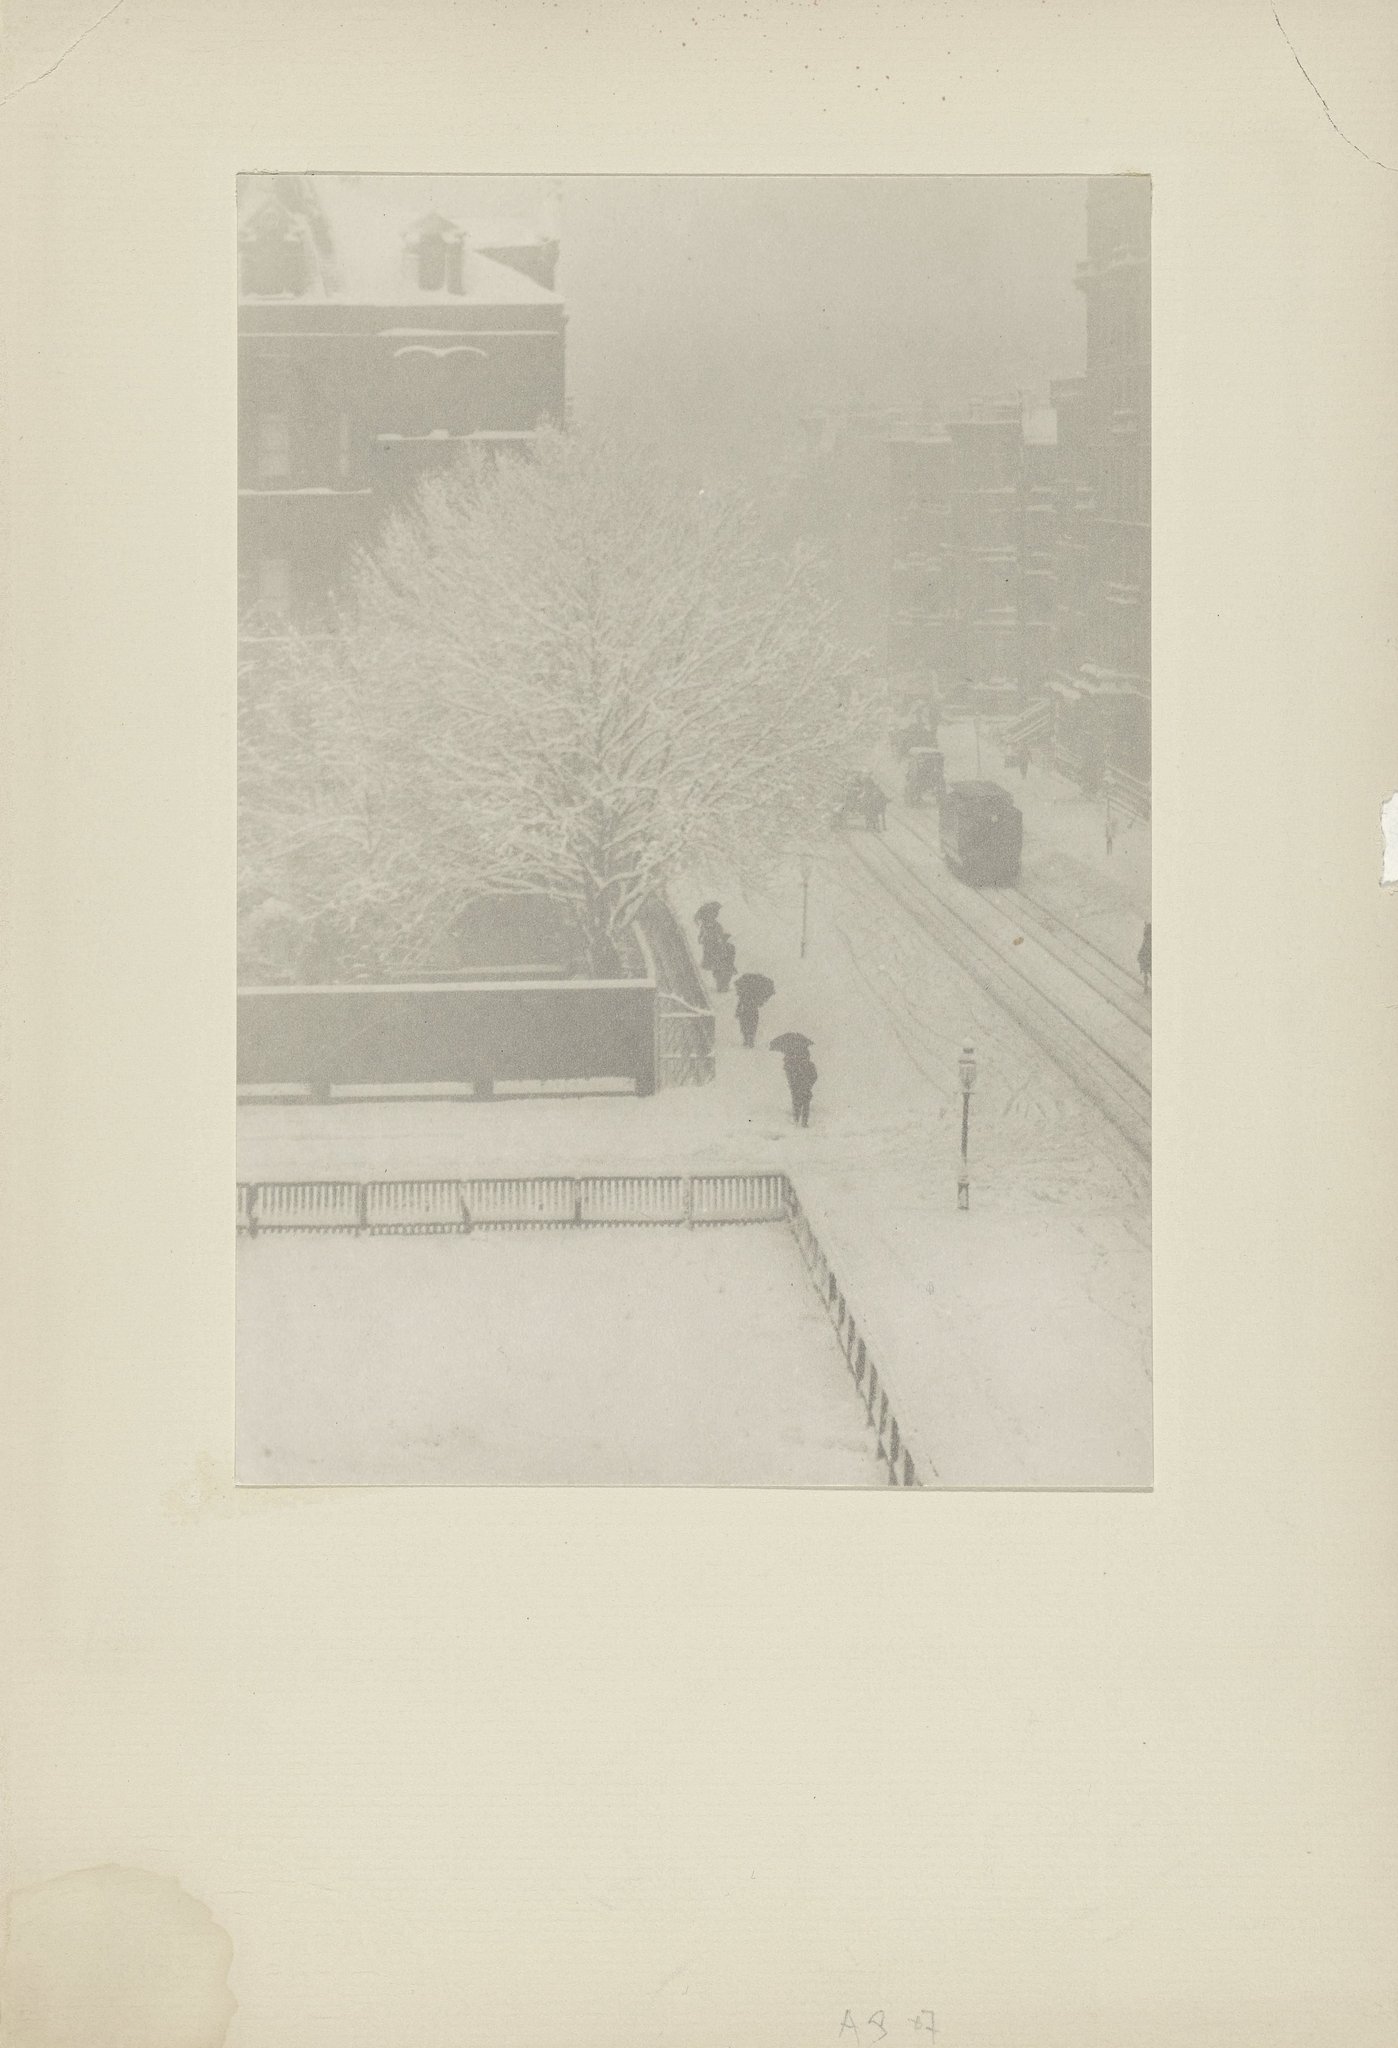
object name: photomechanical print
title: Straatgezicht vanuit het raam van Alfred Stieglitz in New York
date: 1907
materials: paper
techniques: photoaquatint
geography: new york city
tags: window, new york (city)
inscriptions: number: ‘AS 07’, number: ‘JES 51880P’